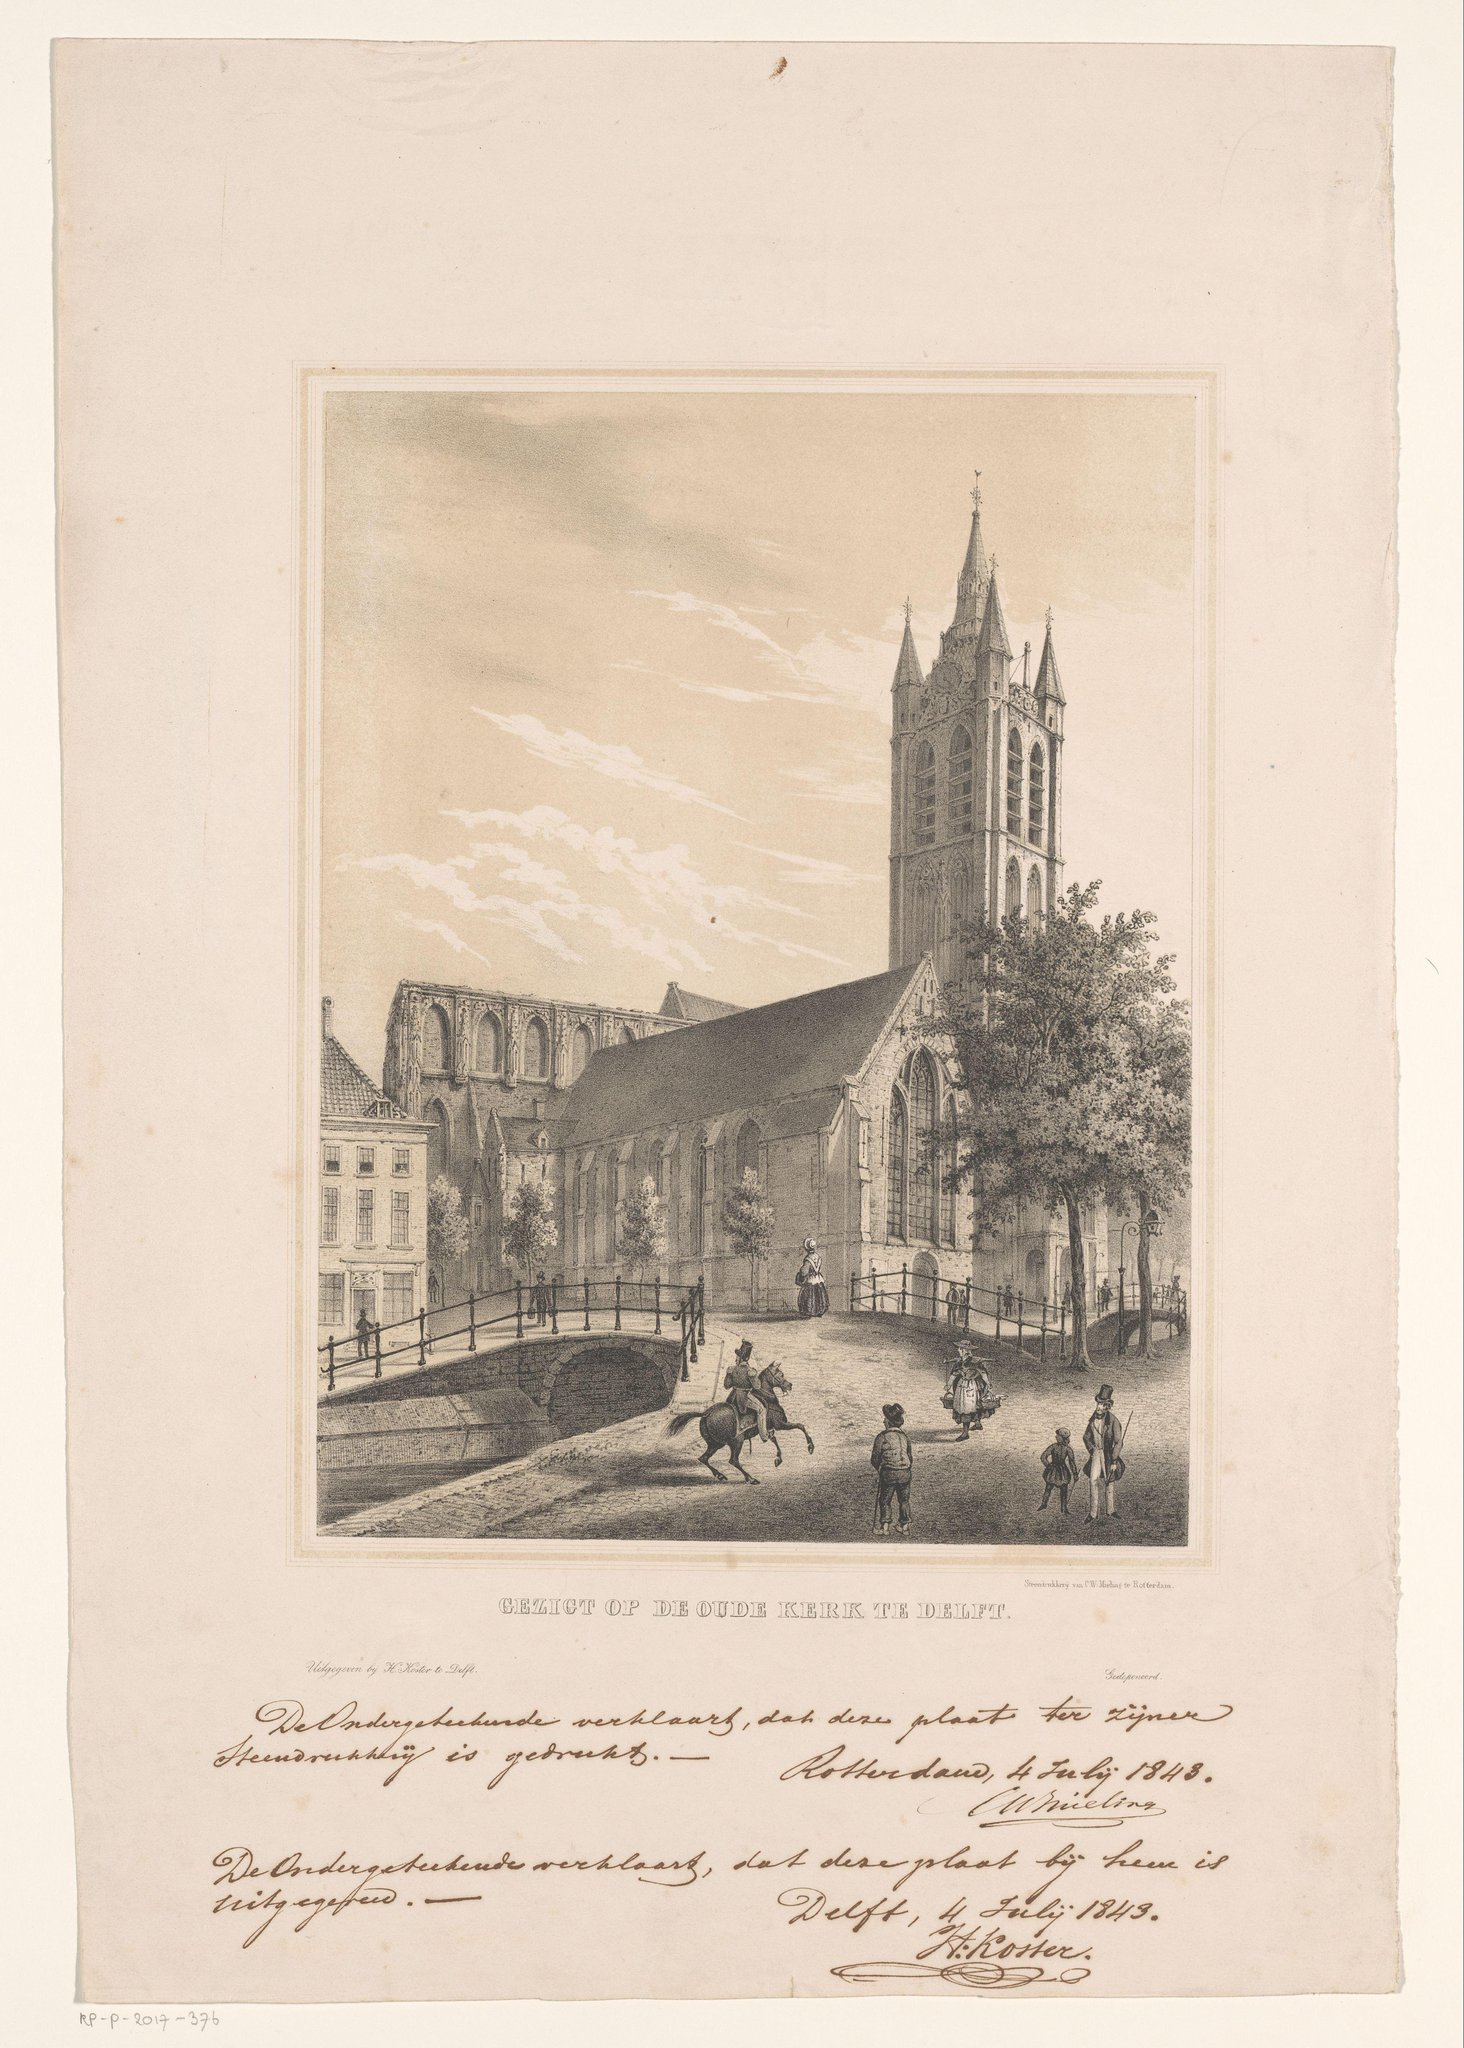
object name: print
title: Gezicht op de oude kerk te Delft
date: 1848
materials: paper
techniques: tone lithography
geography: delft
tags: building of church, canals, waters (in city) (+ city(-scape) with figures, staffage)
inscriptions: : ‘De ondergeteekende verklaart, dat deze plaat ter zijner / steendrukkerij is gedrukt. - / Rotterdam, 4 julij 1848 / CWMieling’, : ‘De ondergeteekende verklaart, dat deze laat bij hem is / uitgegeven. - / Delft, 4 julij 1843 / H:Koster’, : ‘Gedeponeerd.’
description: Op de brug voor de kerk lopen figuren en een ruiter.